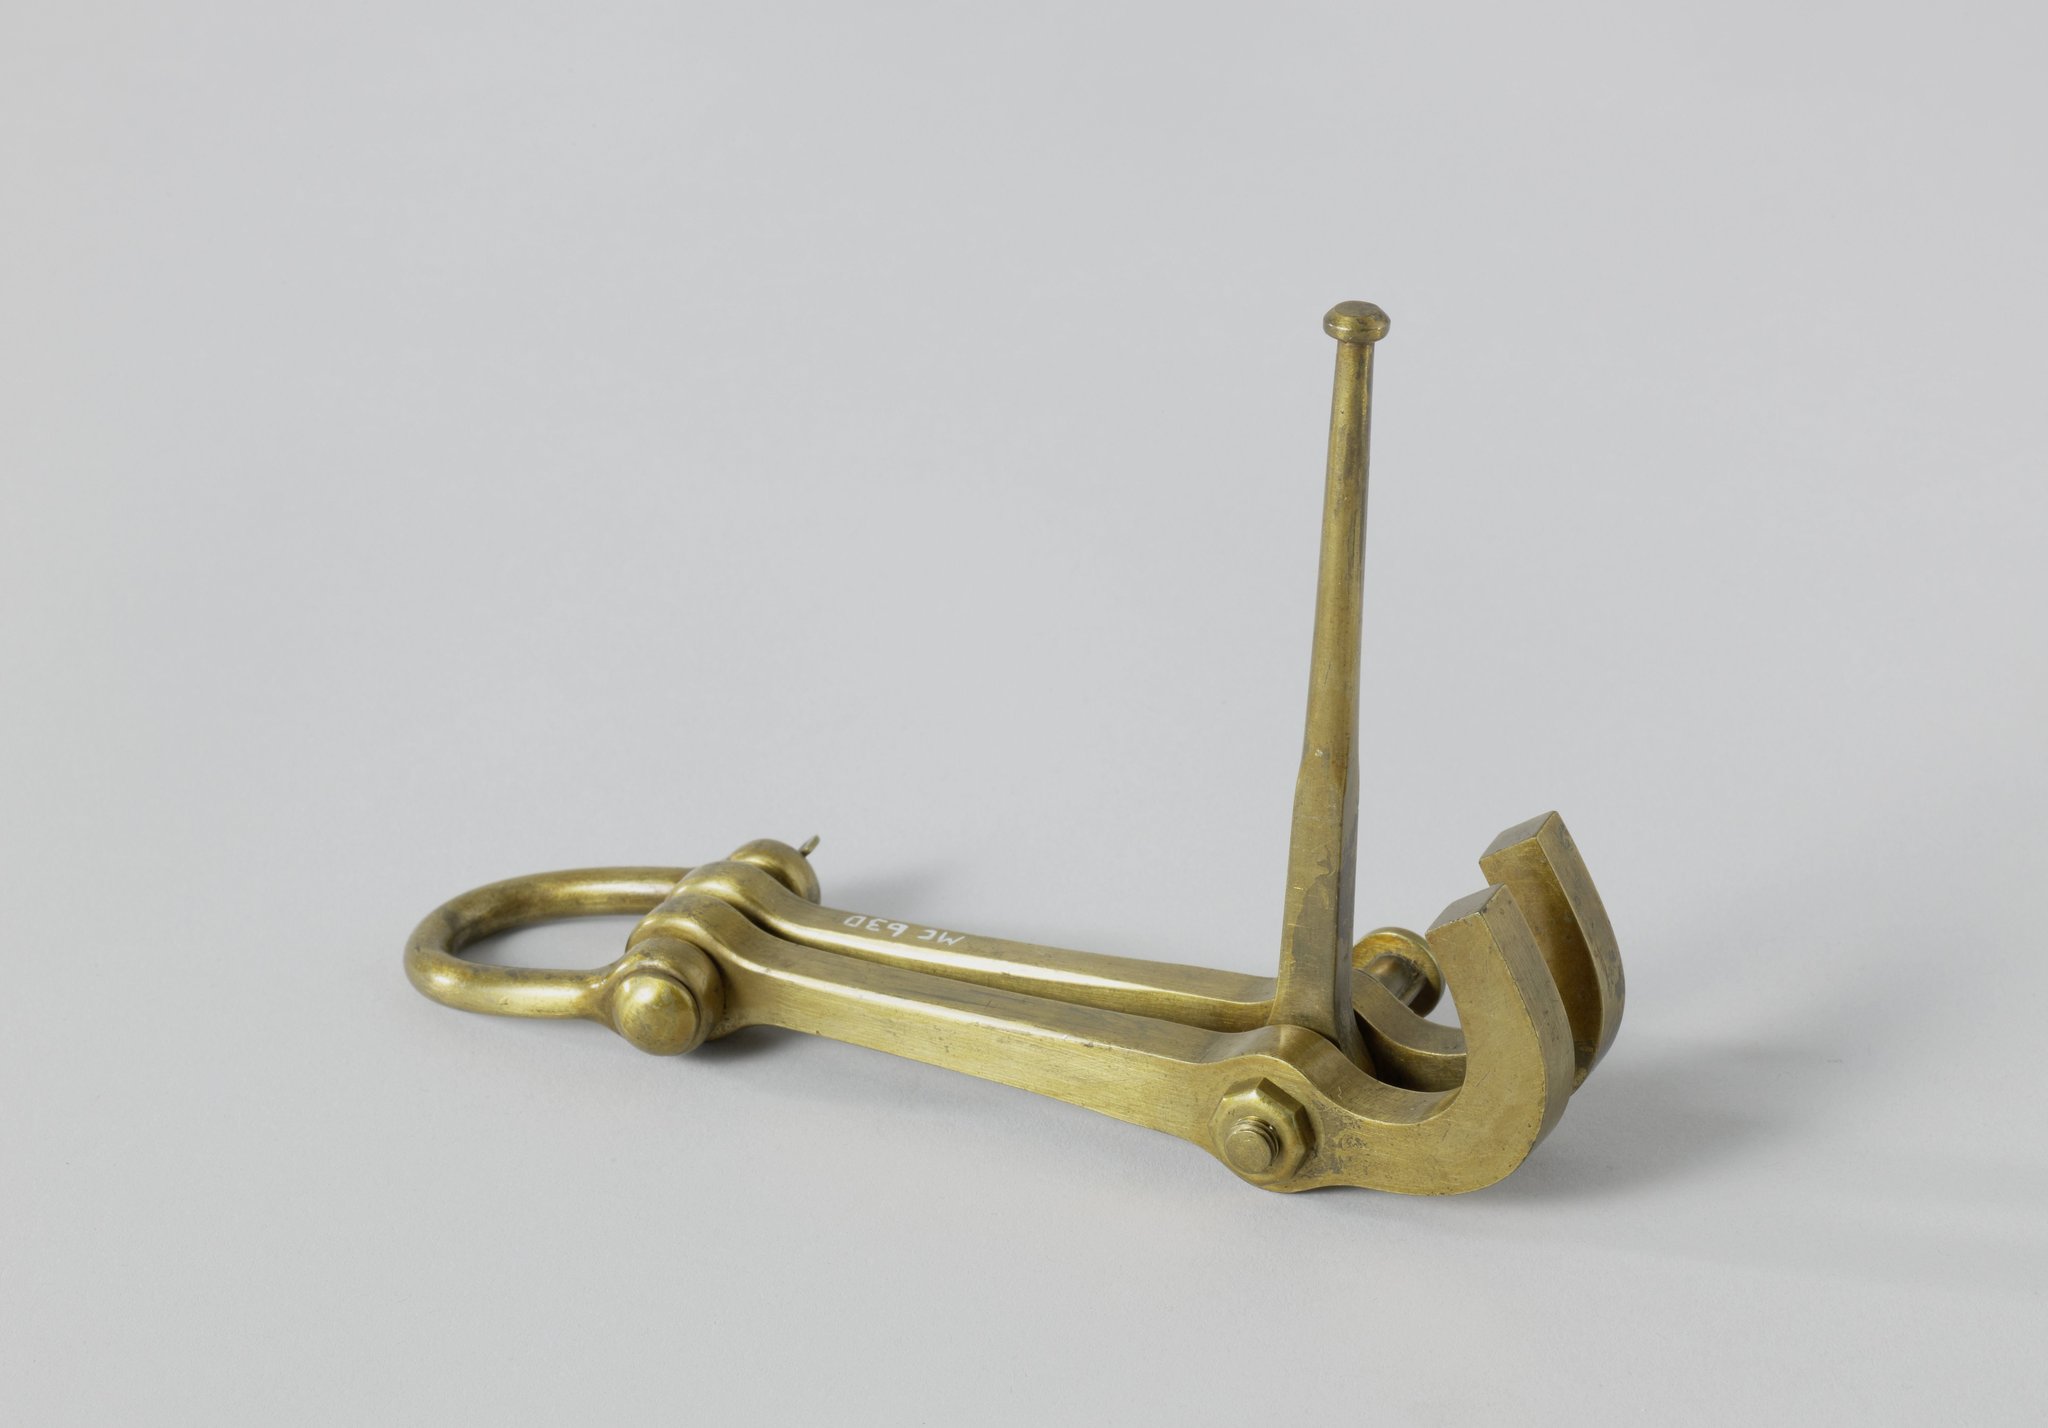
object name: demonstration model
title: Model of a Chain Stopper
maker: Anonymous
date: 1840-1850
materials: brass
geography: netherlands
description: Model van een kettingstopper, bestaande uit een duivelsklauw met losmaker. Het bestaat uit twee parallelle haken, verbonden door middel van een harp aan het rechte eind en bij de bocht met een bout. Om deze bout draait een hefboom tussen de benen haken, waarmee de kettingschalm uit de haken kan worden geduwd.